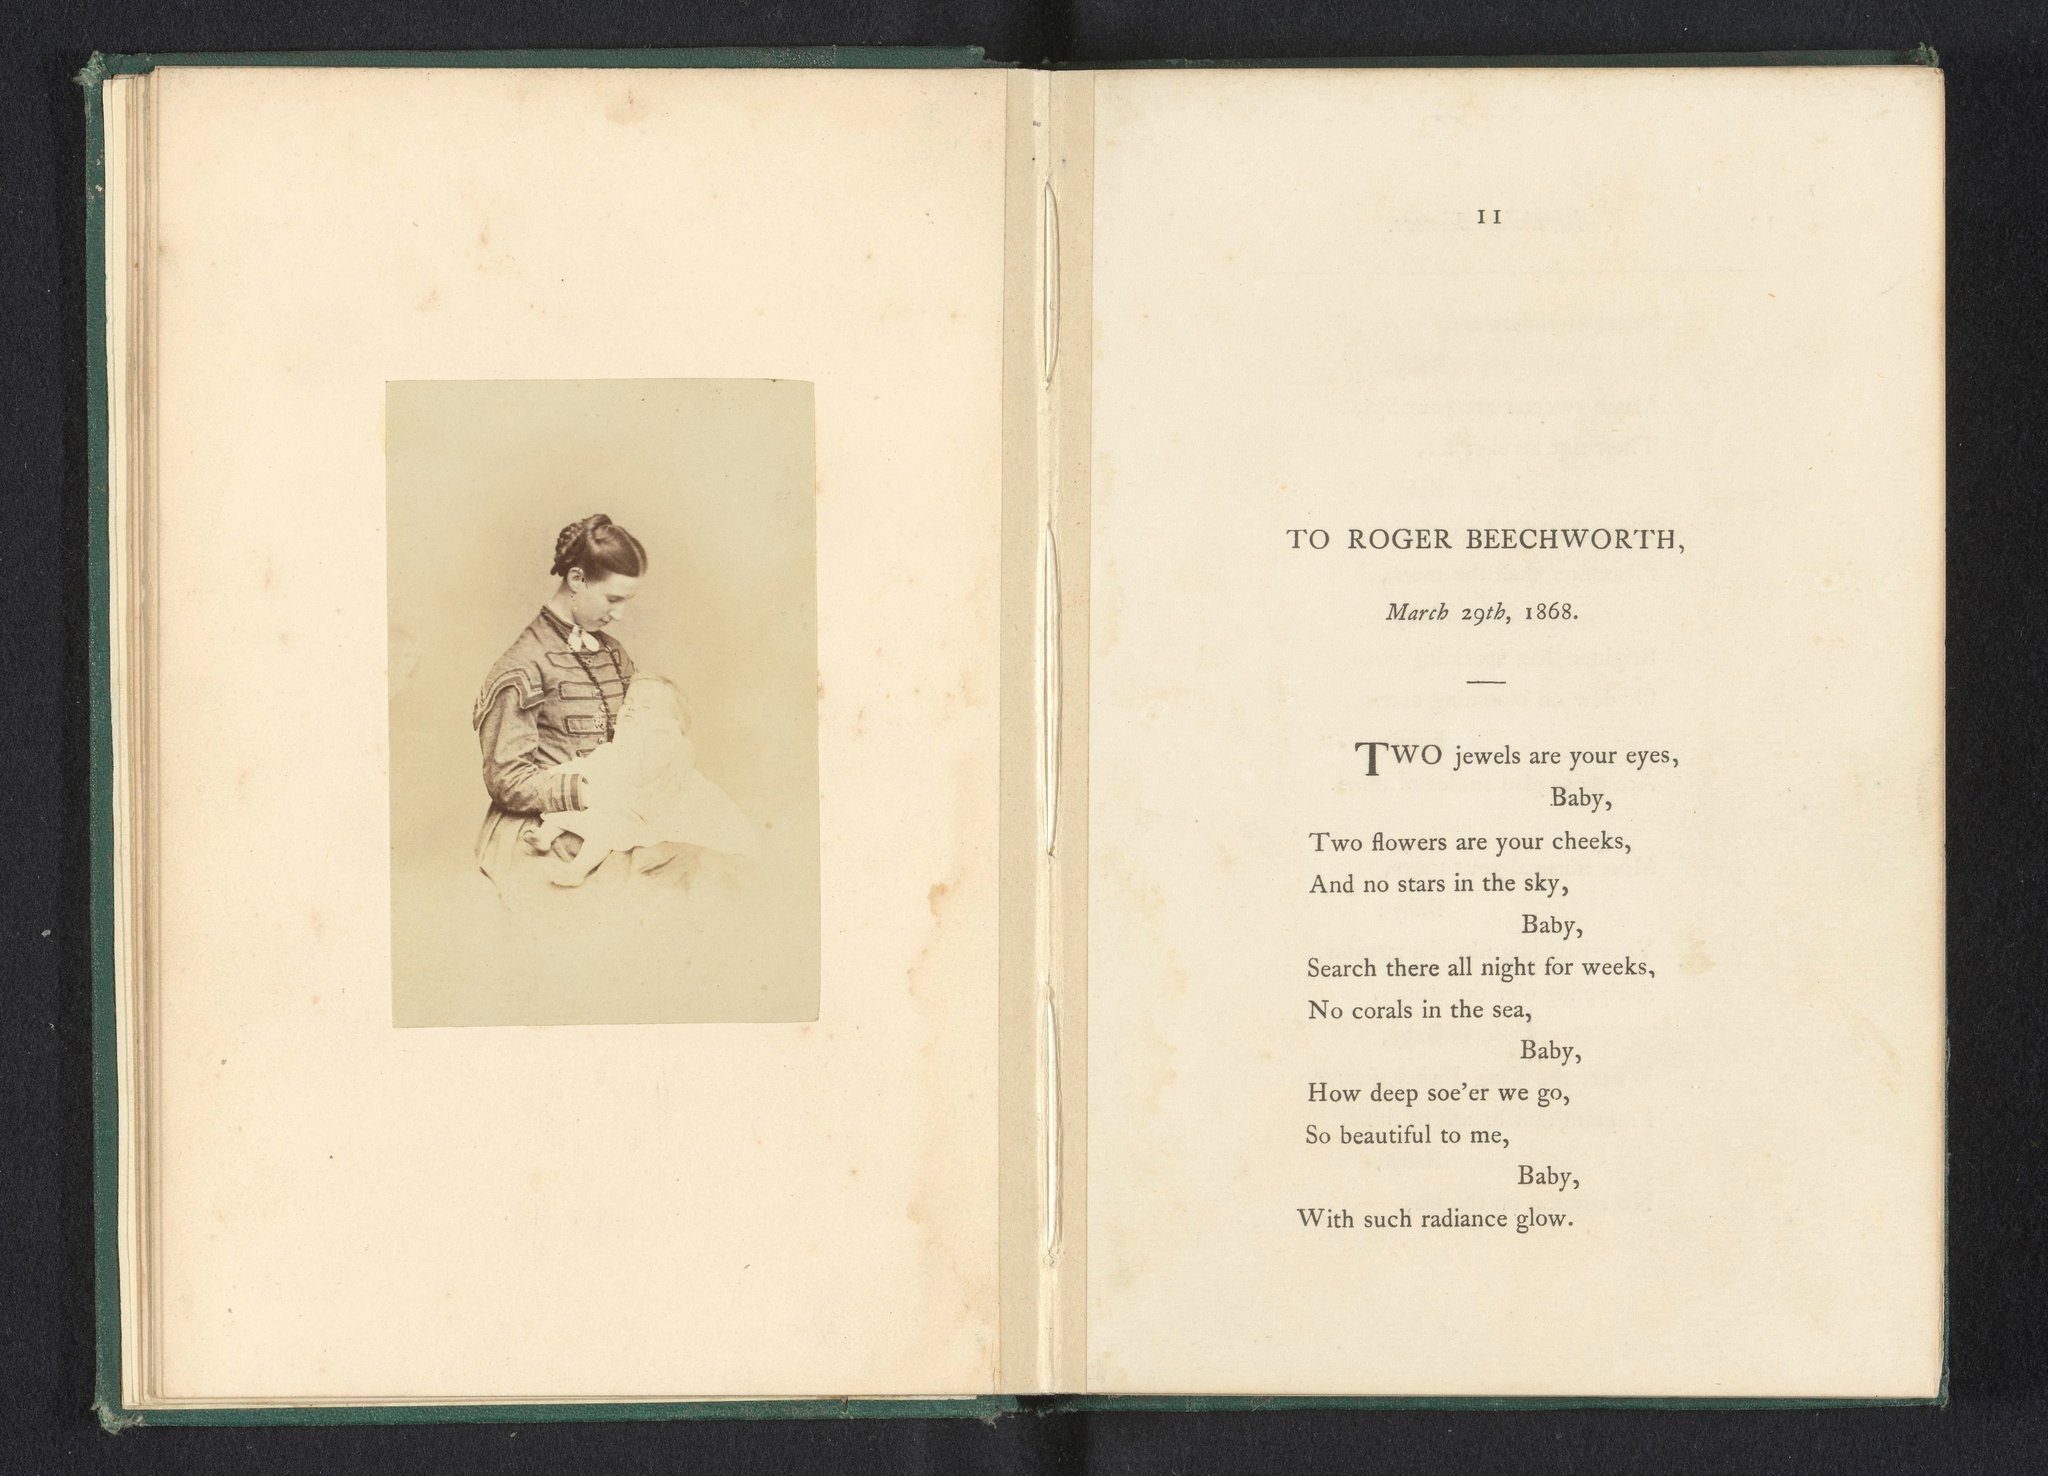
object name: page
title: Portret van (vermoedelijk) Fanny Edith met Roger Beechworth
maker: Anonymous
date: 1863-1868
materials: photographic support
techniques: albumen print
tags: mother and baby or young child